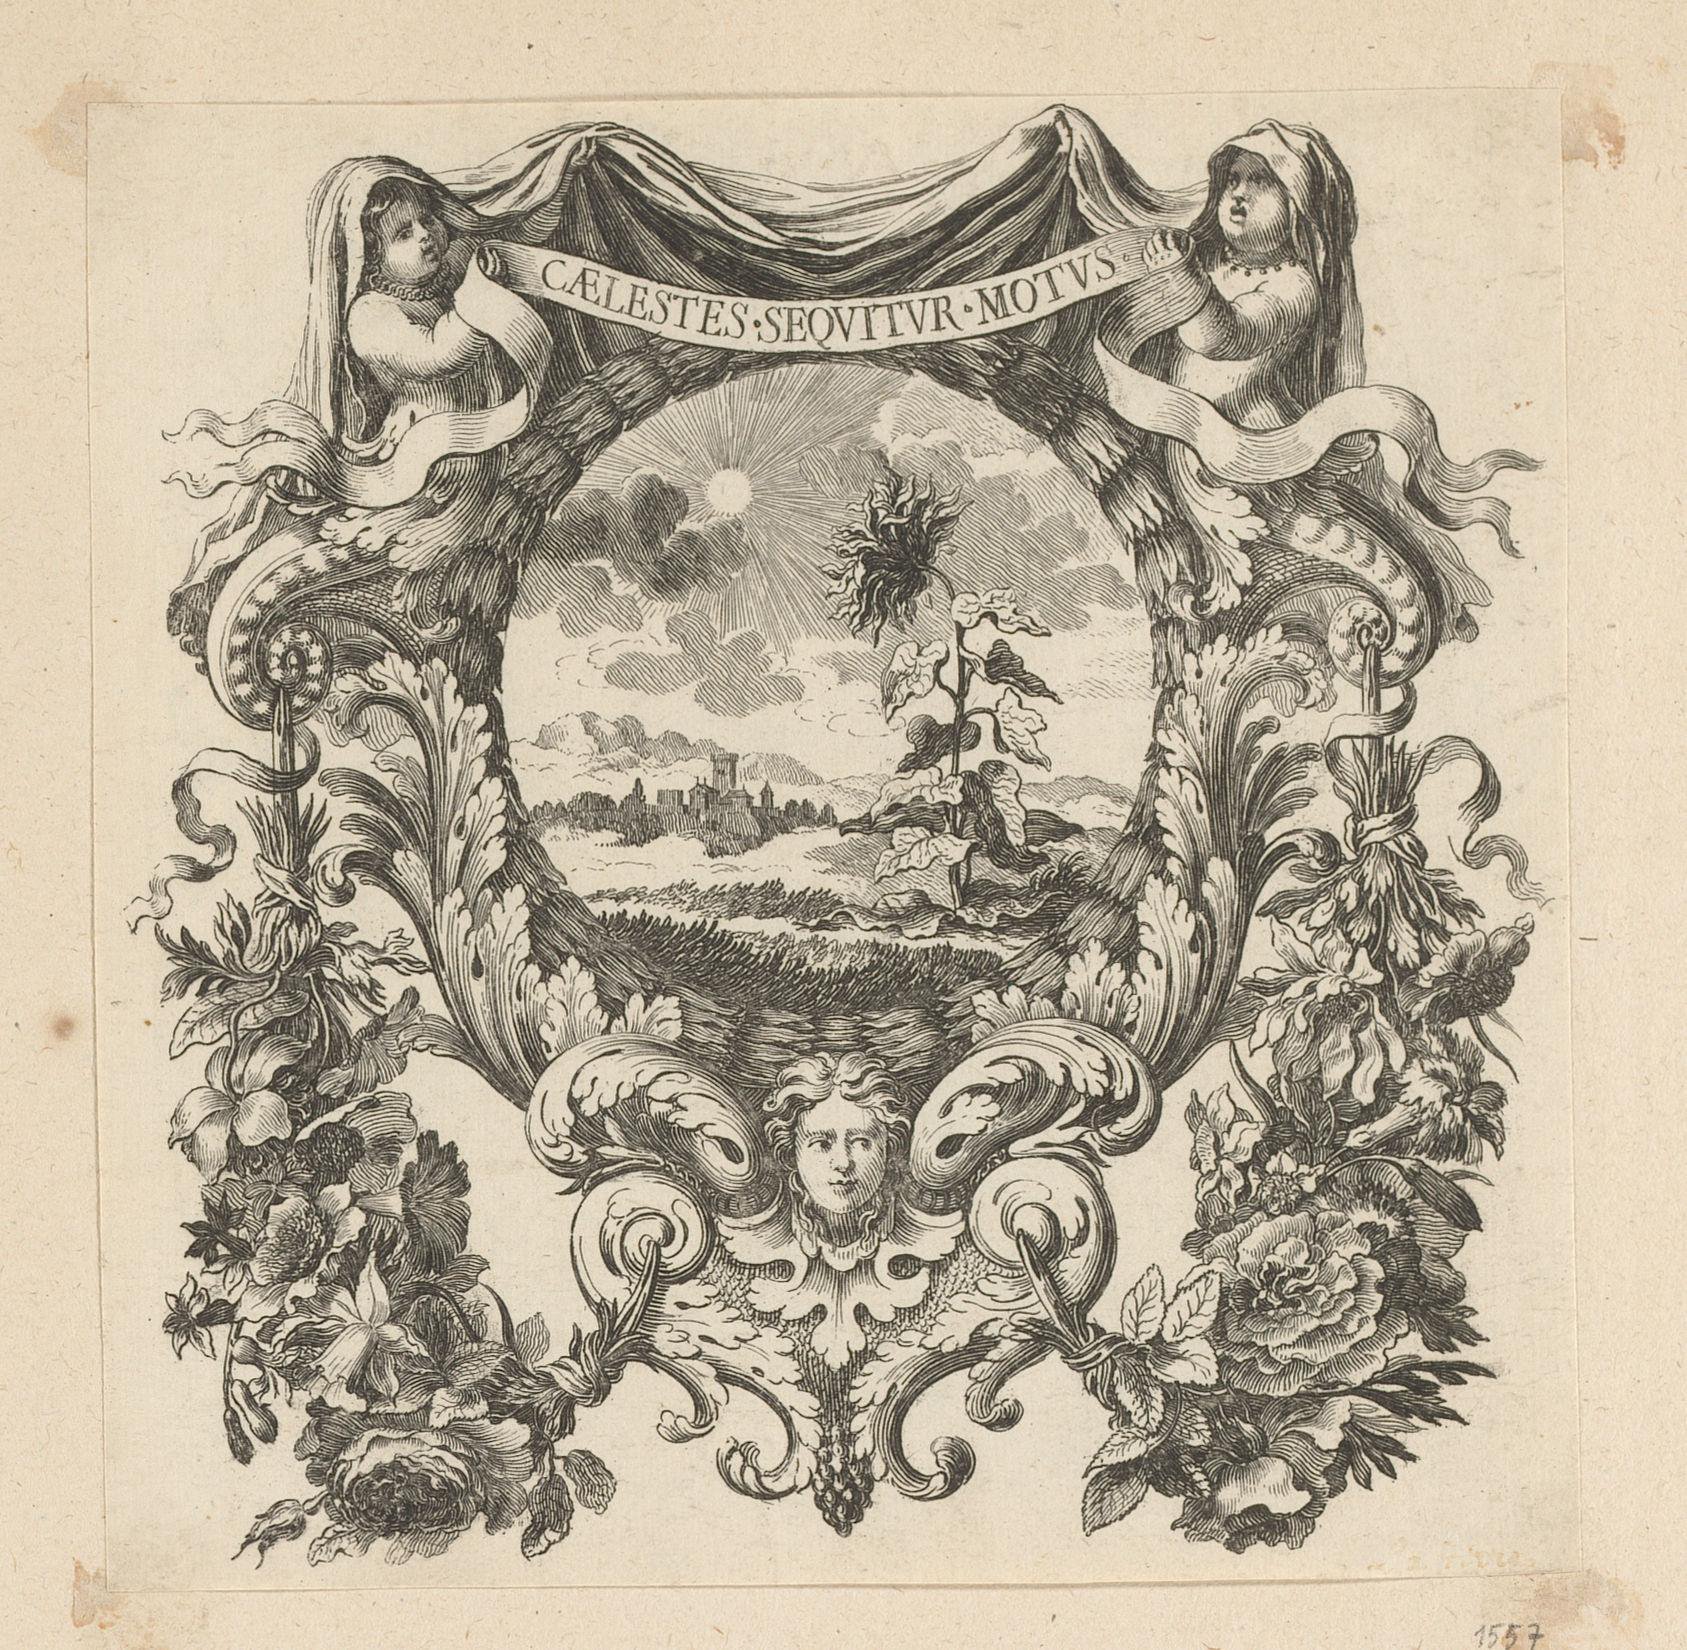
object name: print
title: Caelestes sequitur motus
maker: sébastien leclerc (i)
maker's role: print maker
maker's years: 1637-1714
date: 1670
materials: paper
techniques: etching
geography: paris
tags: flowers: sunflower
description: Prent gebruikt voor: Félibien, André. Devises pour les tapisseries du Roy, où sont représentez les quatre éléments et les quatre saisons de l'année (...). Parijs: Imprimerie Royale, 1670.